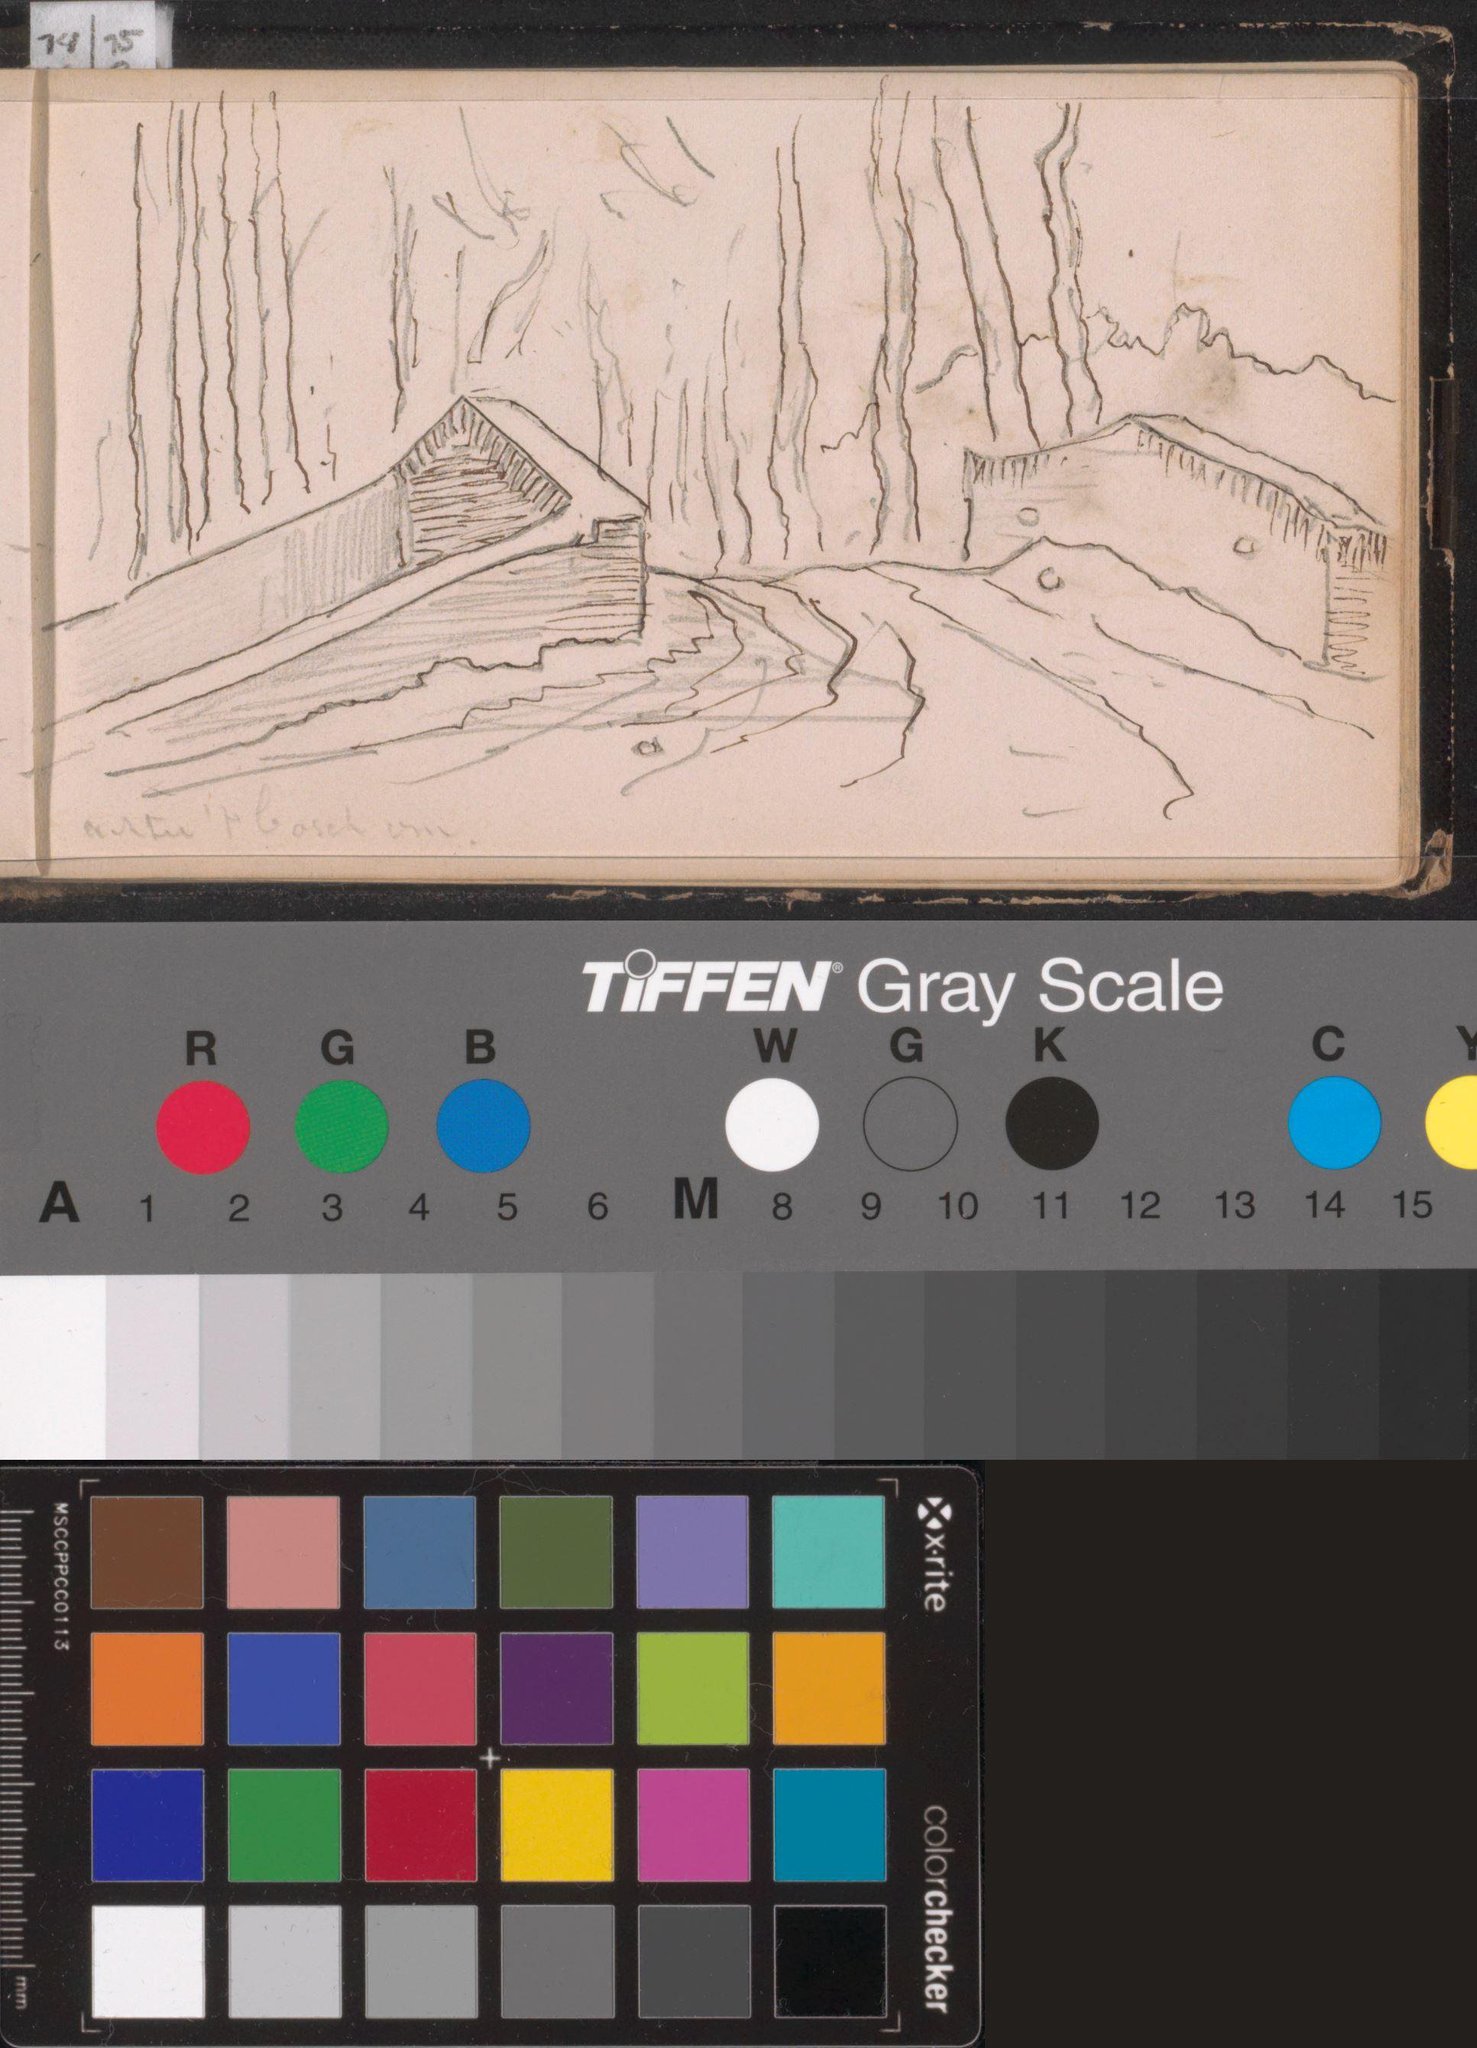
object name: sketchbook leaf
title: Stenen brug bij een bos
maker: johannes tavenraat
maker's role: draughtsman, painter, print maker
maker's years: 1809-1881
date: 1873-1876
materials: ink, paper, pencil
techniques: pen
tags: forest, wood, bridge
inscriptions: annotation: ‘achter 't bosch om.’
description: Blad 15 recto uit een schetsboek met 46 bladen.